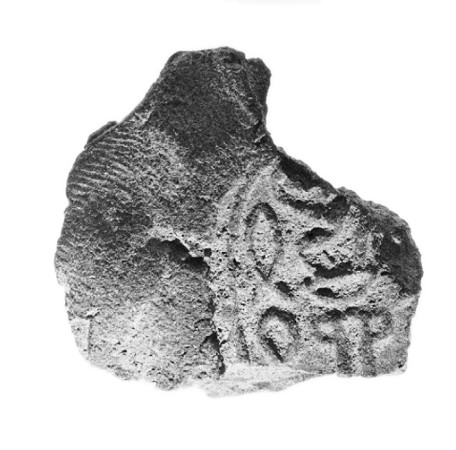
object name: sealing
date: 1981-1640 BCE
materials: mud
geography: egypt